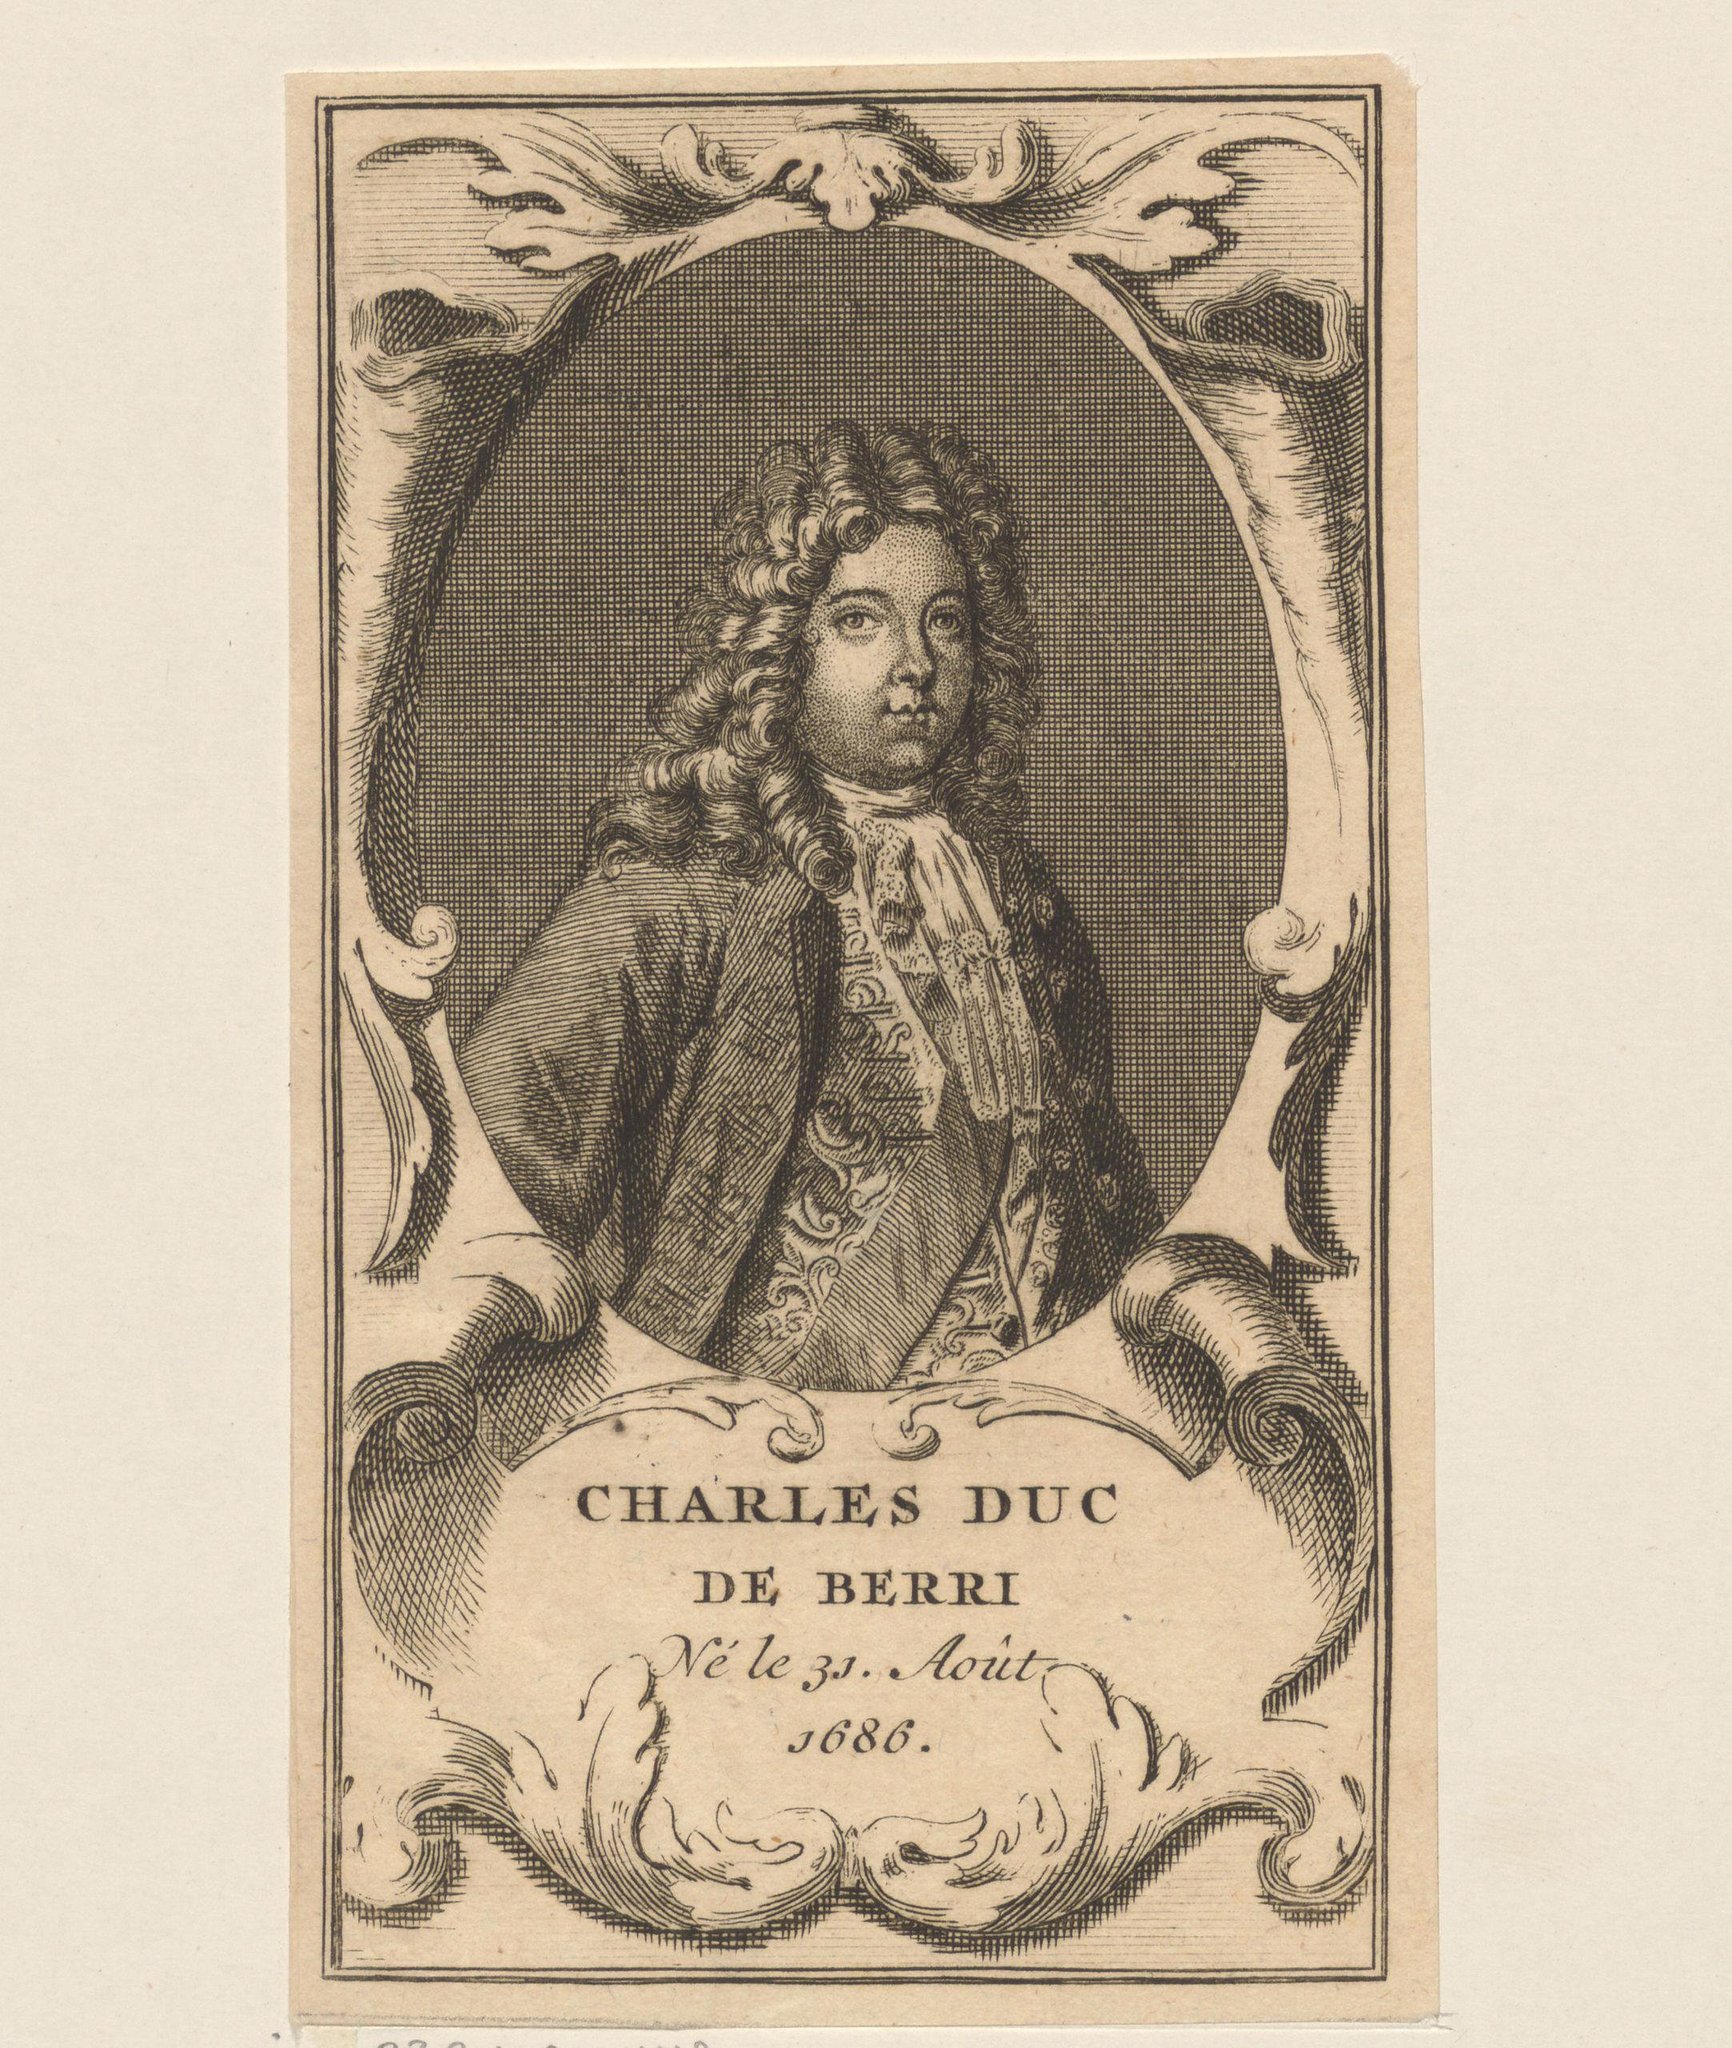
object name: print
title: Portret van Karel van Frankrijk, hertog van Berry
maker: Anonymous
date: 1700-1749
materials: paper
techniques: engraving, etching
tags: historical persons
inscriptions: collector's mark: Lugt 2228